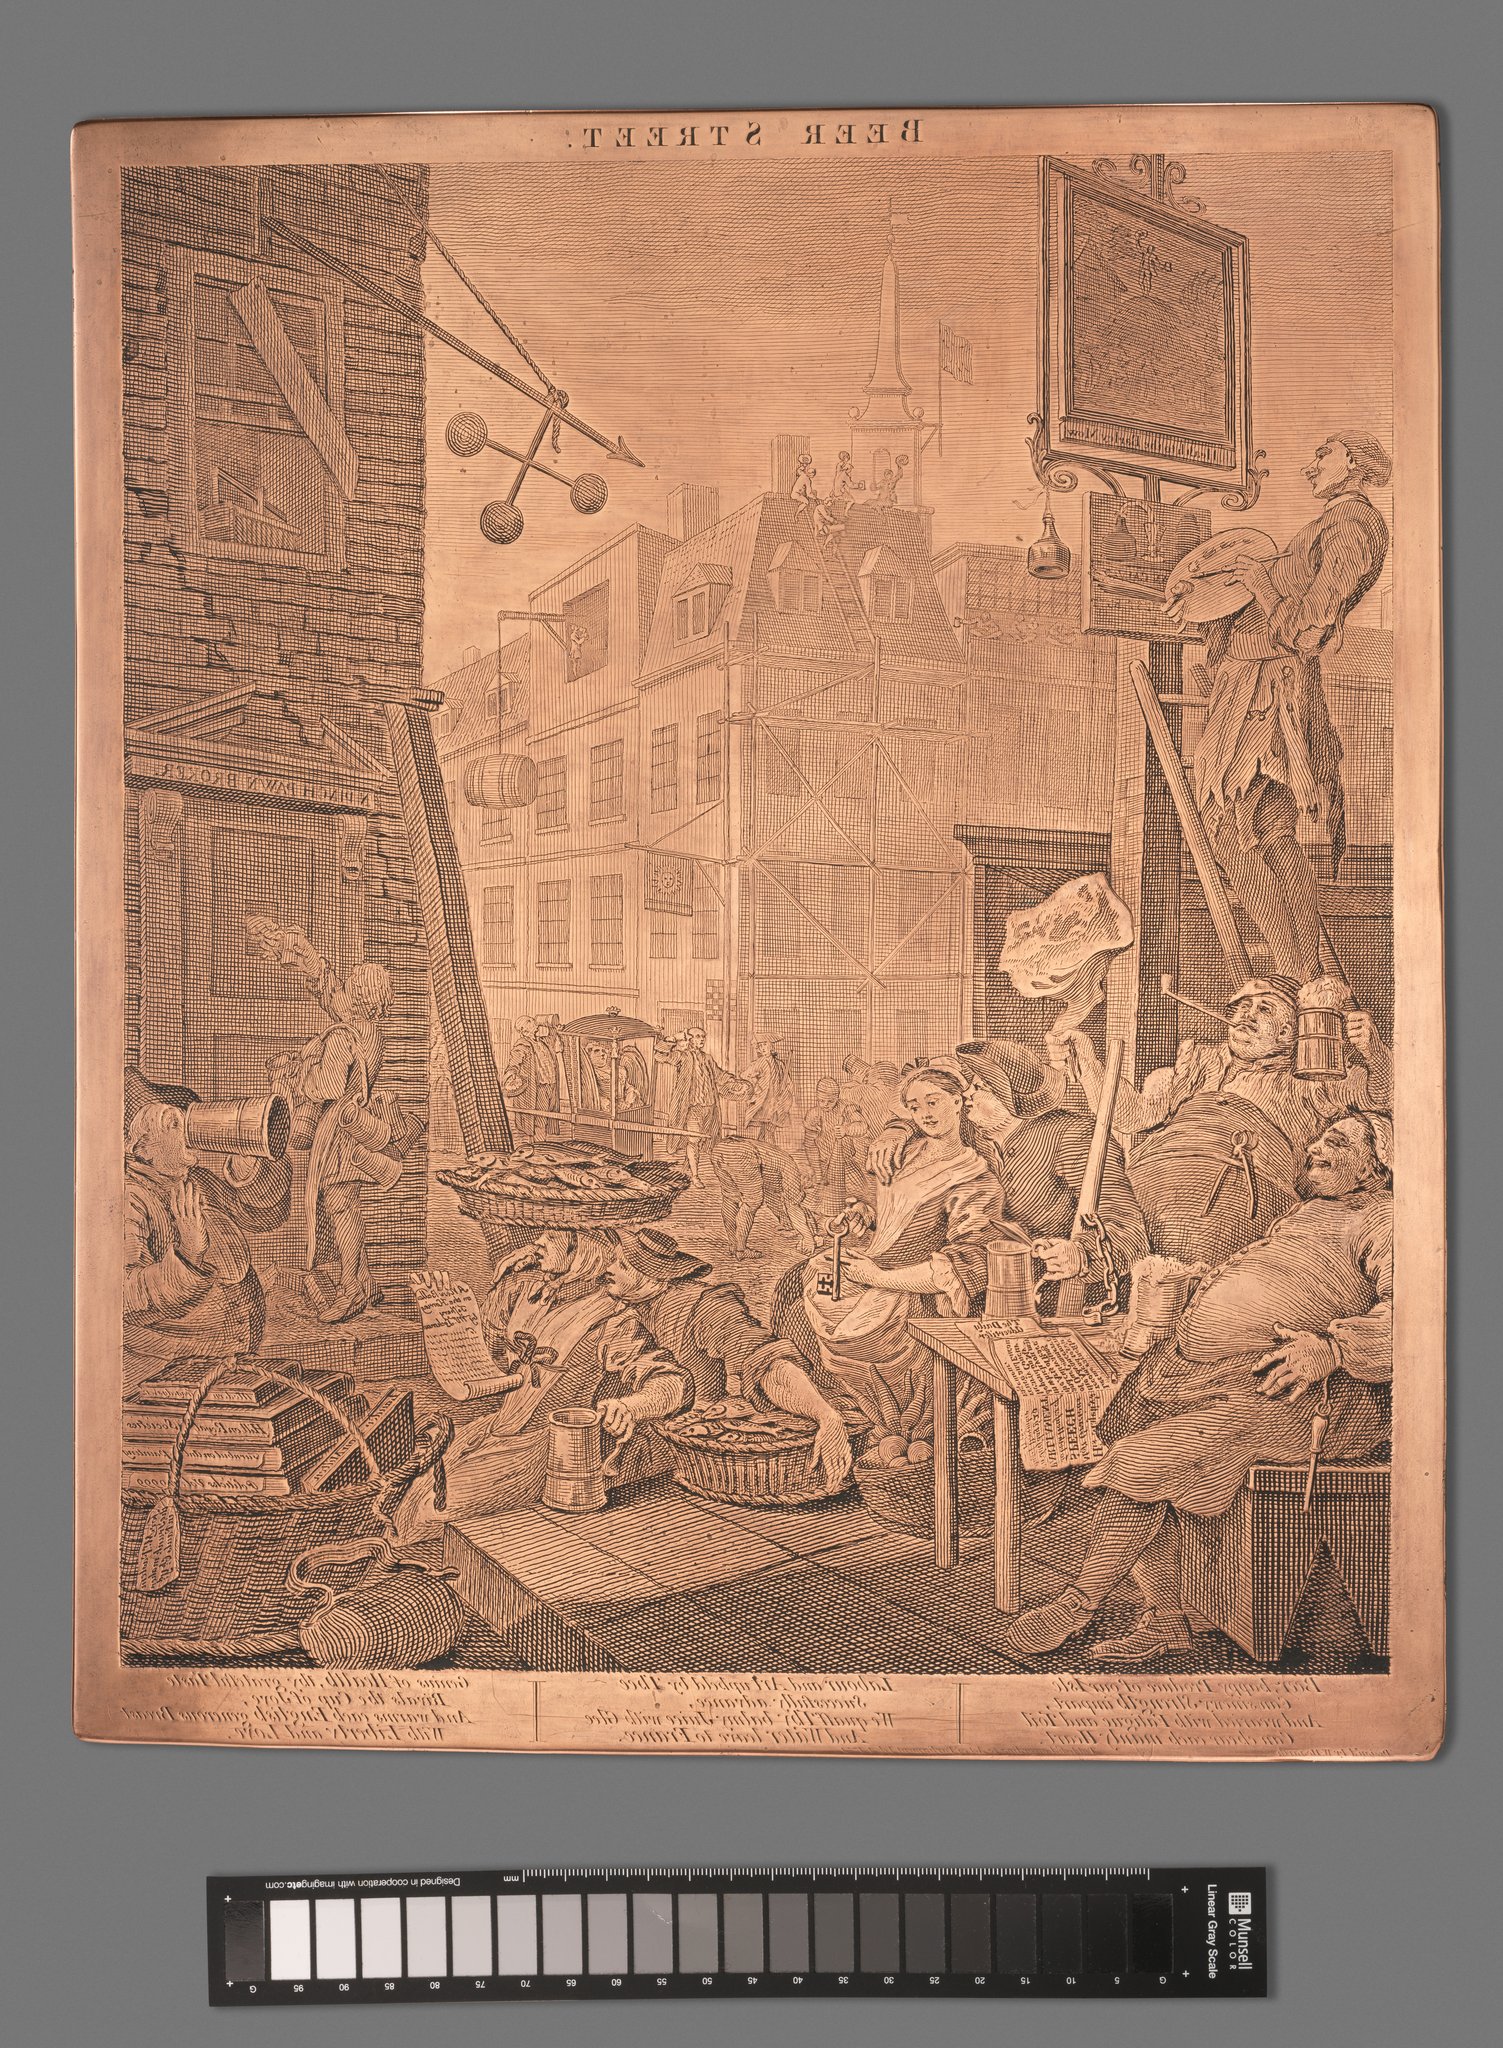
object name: plate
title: Beer Street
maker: william hogarth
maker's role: artist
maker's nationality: british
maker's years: 1697-1764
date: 1751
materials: copper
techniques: engraving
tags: satire,men,women,fish,drinking